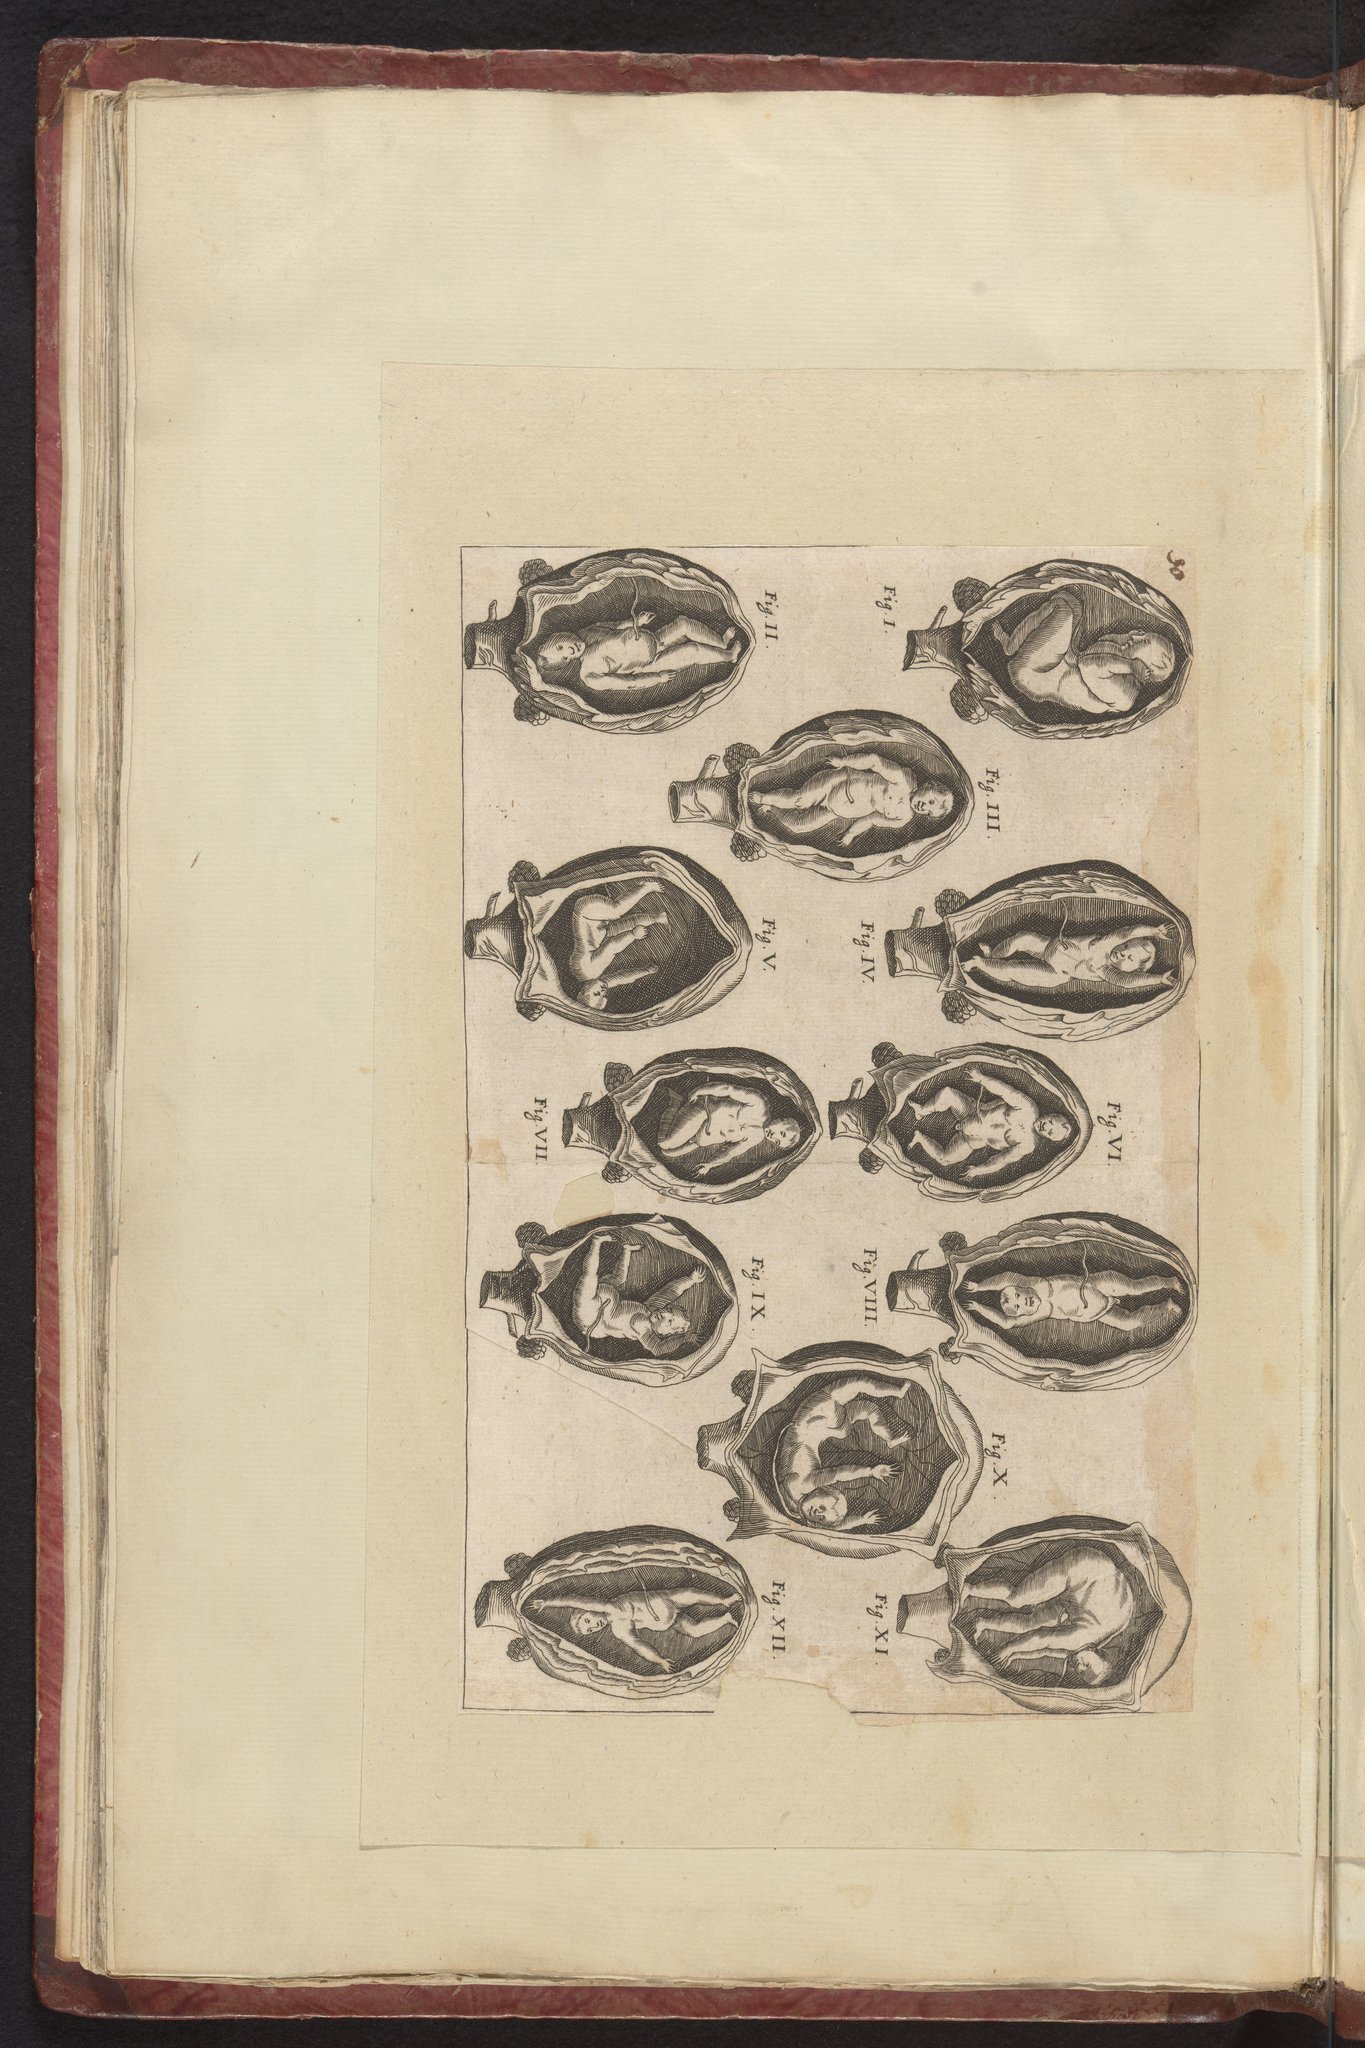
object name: print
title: Foetus in de baarmoeder in twaalf figuren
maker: Anonymous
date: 1665-1667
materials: paper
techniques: engraving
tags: uterus with foetus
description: Ingeplakte prent met twaalf posities van de foetus in de baarmoeder, Fig. I-XII. Linksboven genummerd: 30. Onderdeel van het zevende album met tekeningen van reptielen, amfibieën en natuurhistorische ensembles. Het zevende van twaalf albums met aquarellen van dieren, vogels en planten bekend rond 1600, gemaakt in opdracht van keizer Rudolf II. Met toelichting in Nederlands, Latijn en Frans.